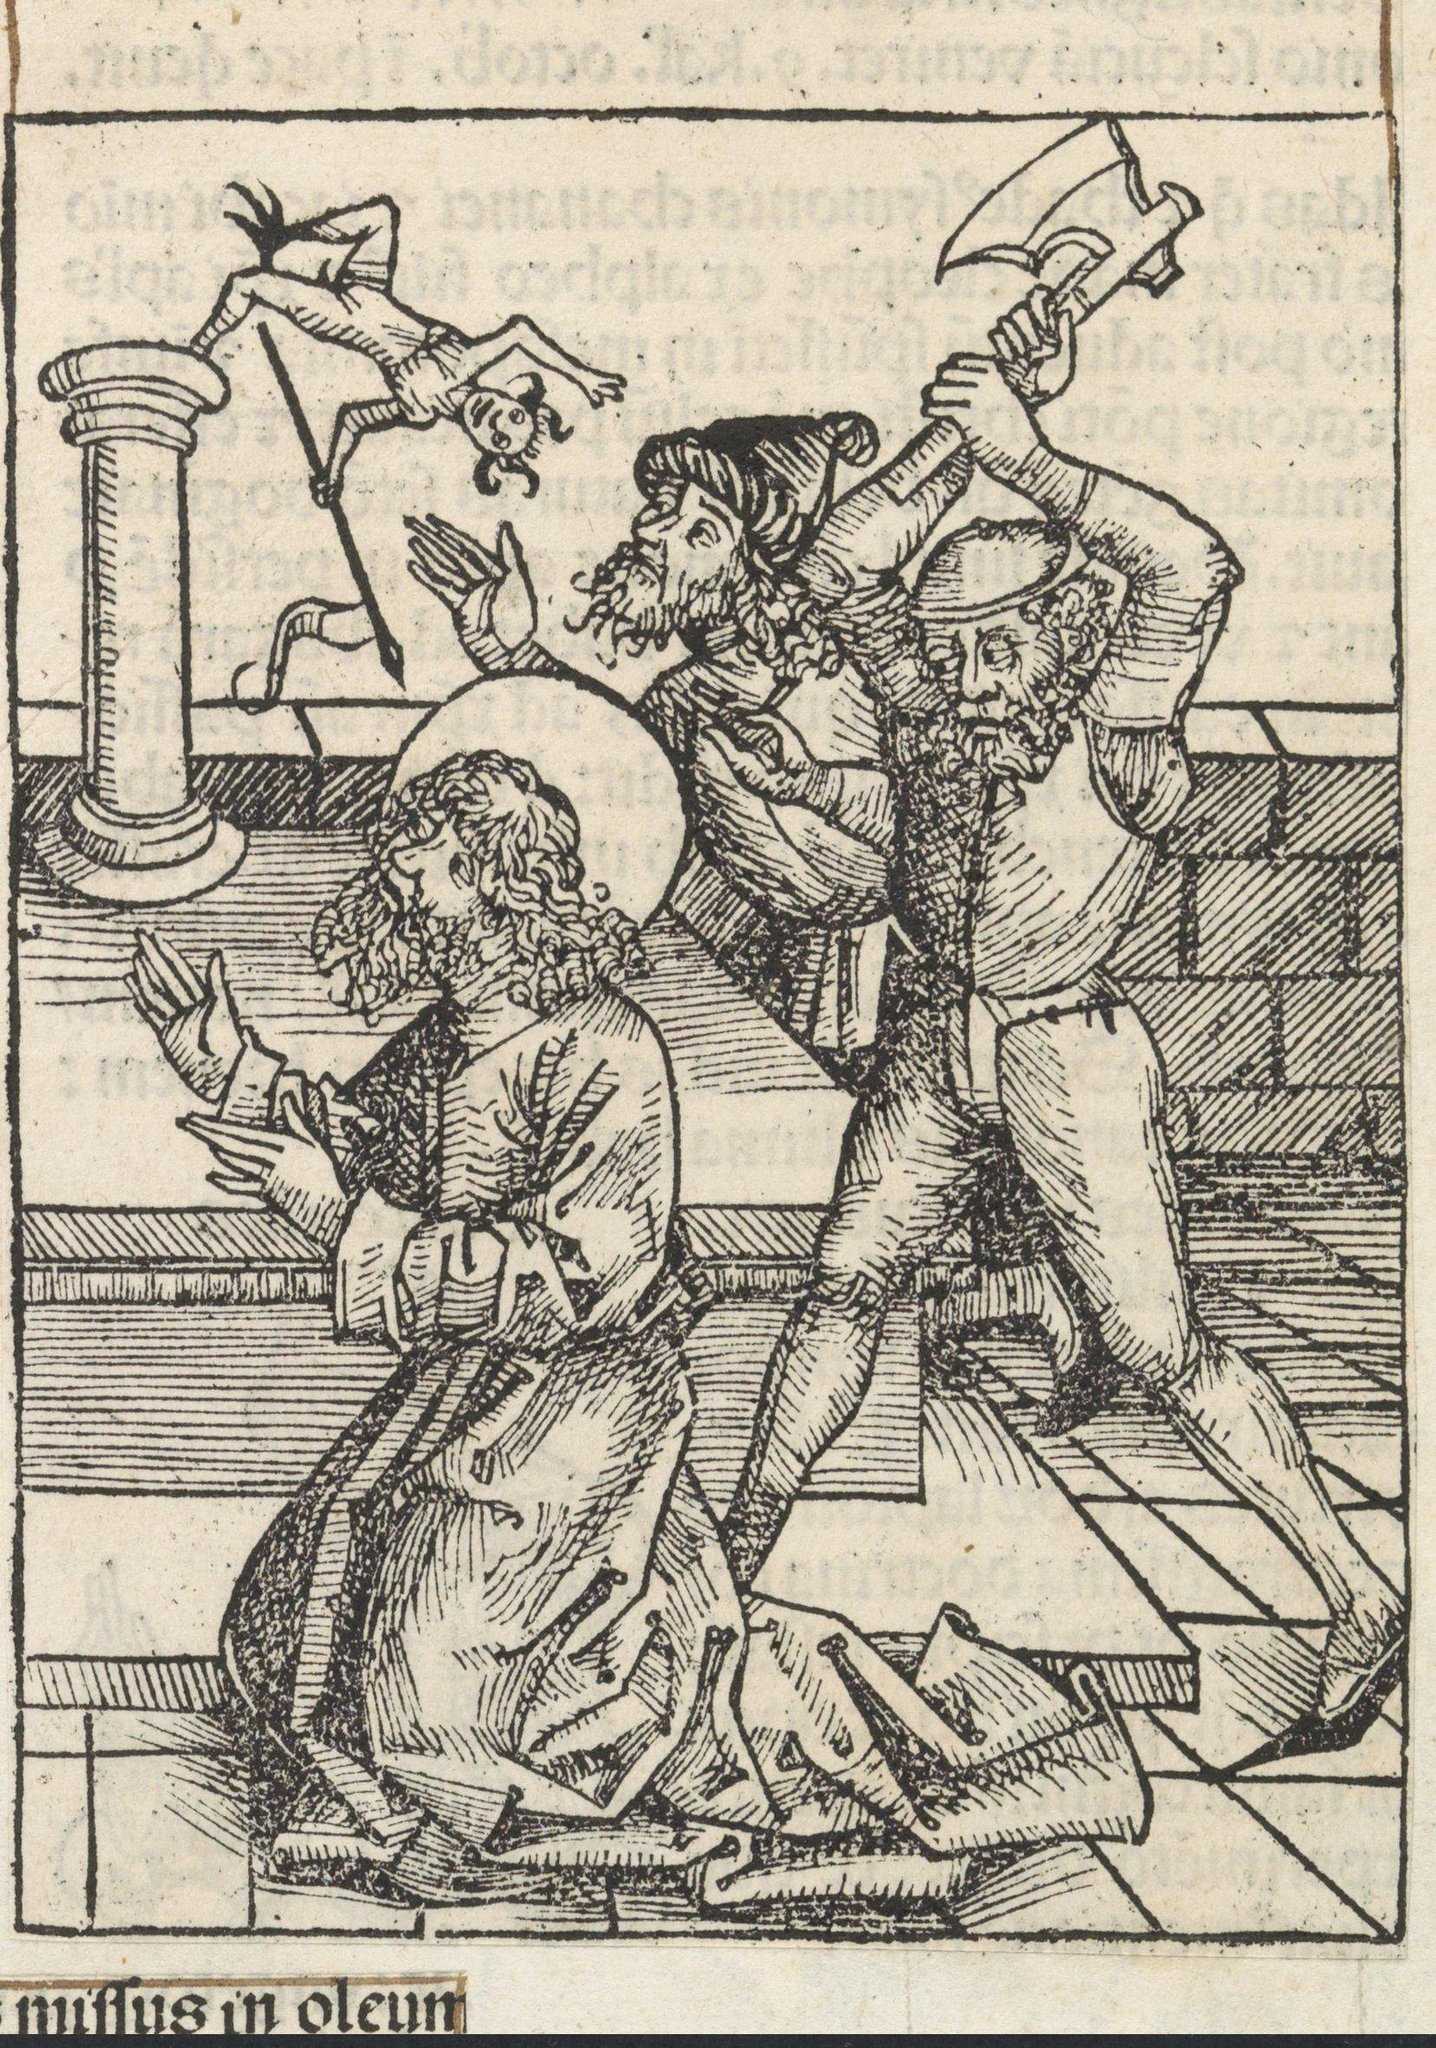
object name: album leaf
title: Marteldood van Mattias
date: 1493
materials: paper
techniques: letterpress printing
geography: nuremberg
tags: martyrdom and death of matthias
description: De houtsnede wordt gebruikt als boekillustratie in de Liber Chronicarum (of Neurenbergkroniek) van Hartmann Schedel, verschenen in het Latijn en Duits in 1493. Zie de Latijnse uitgave, folio 107v.